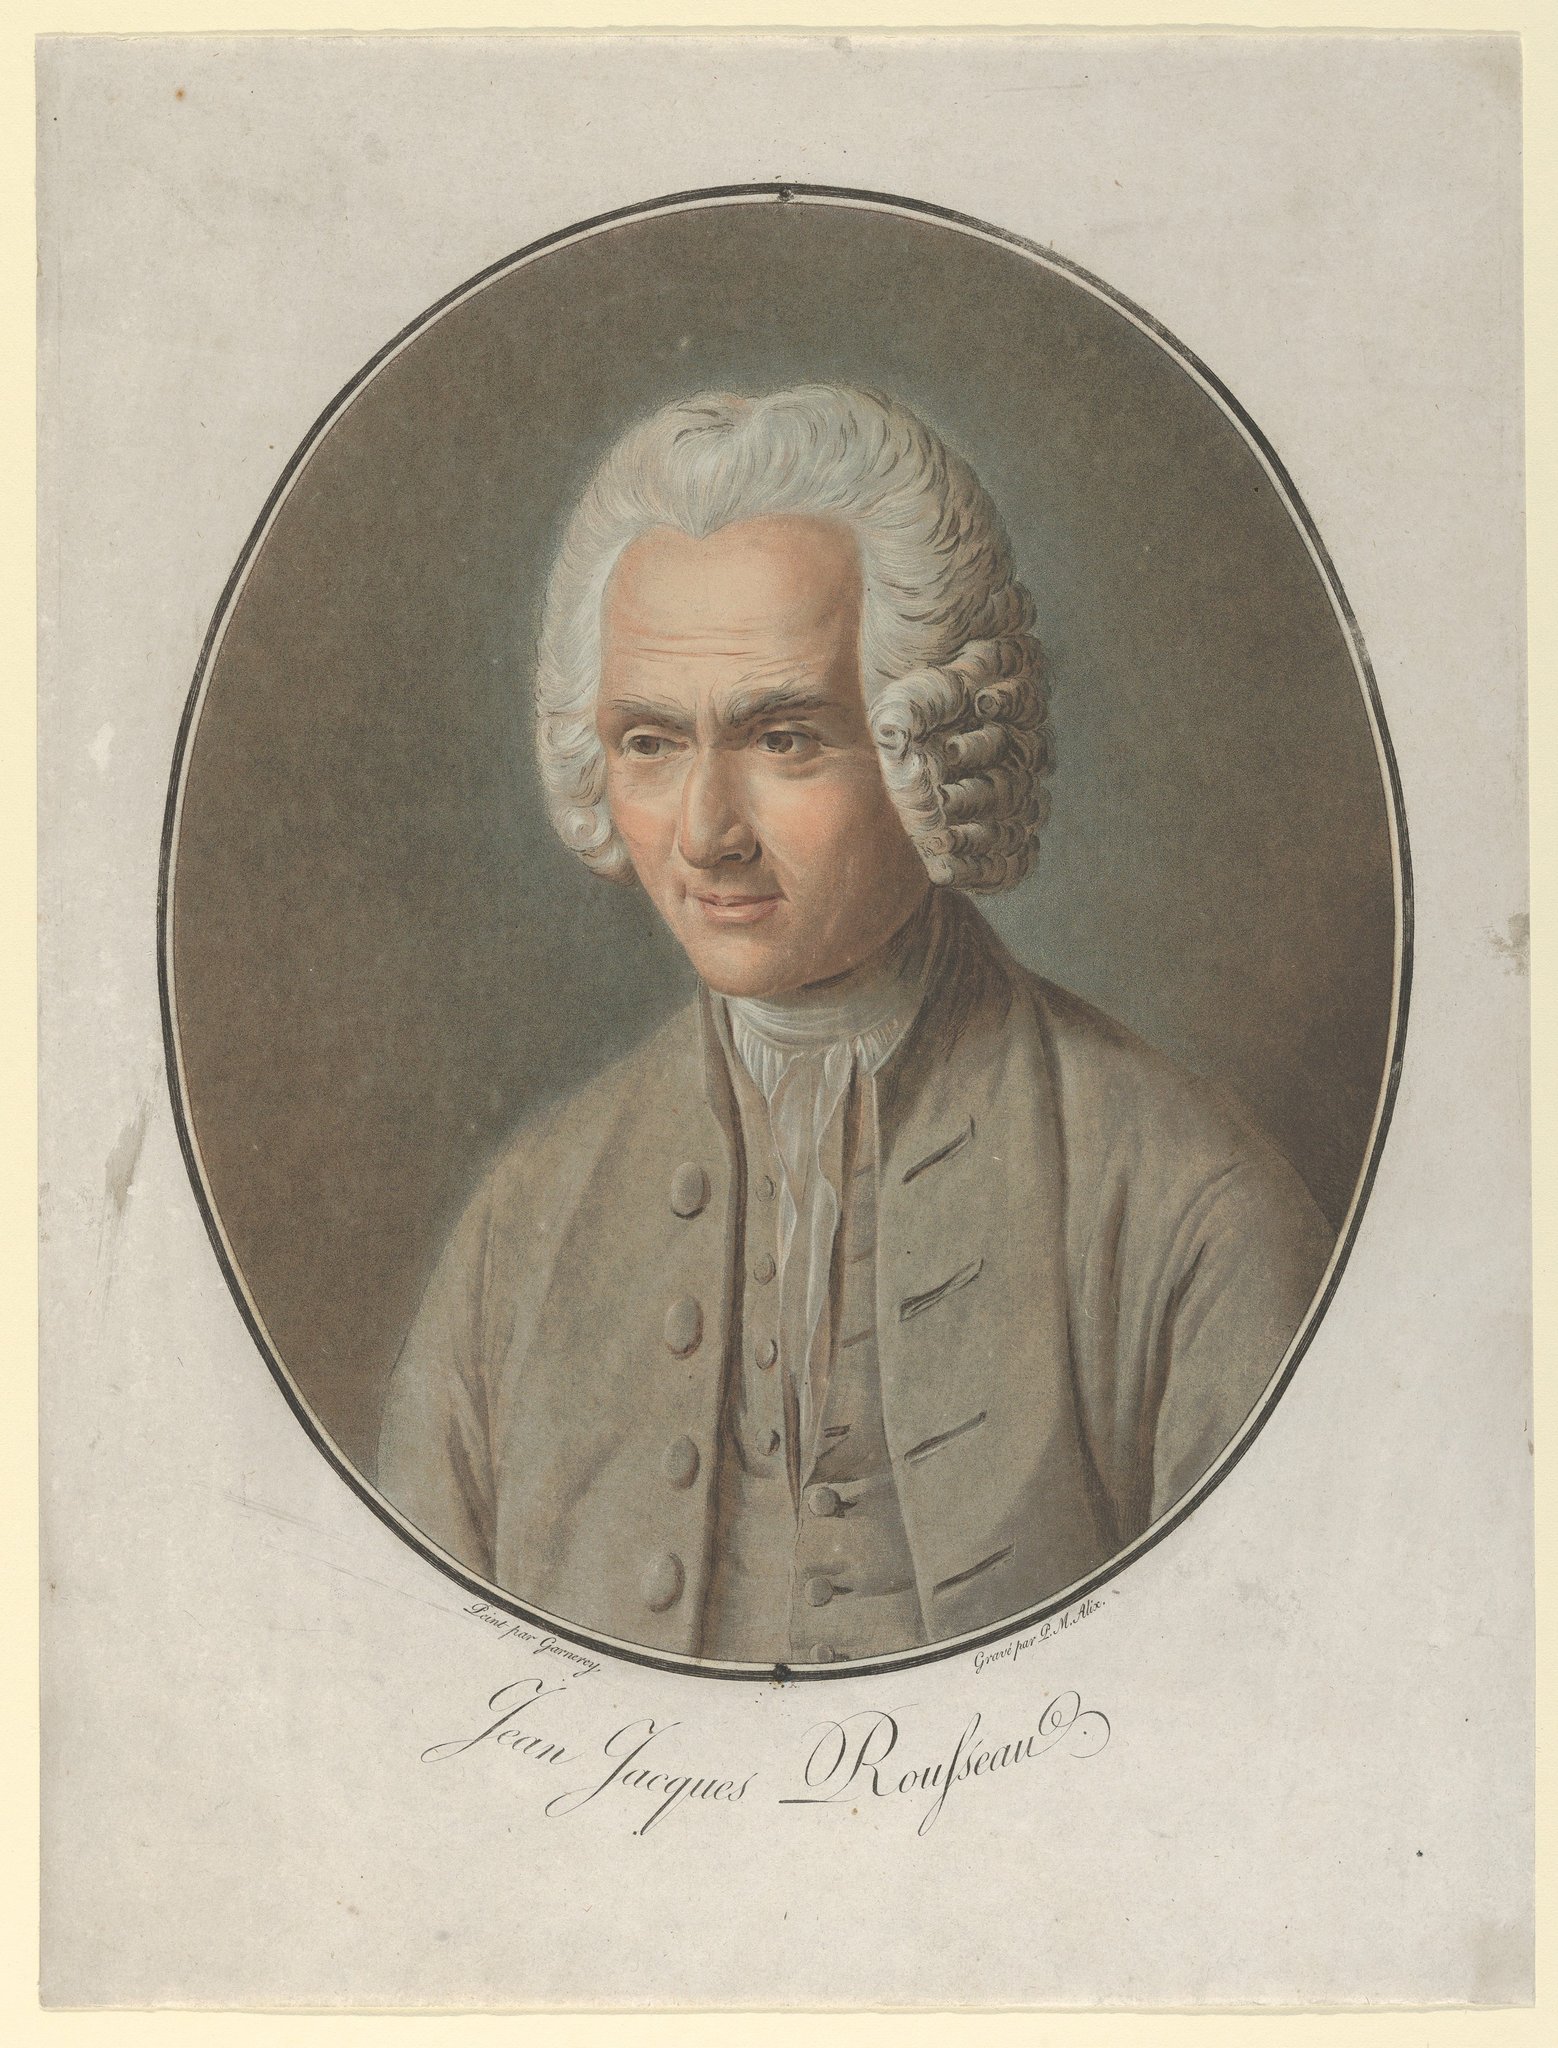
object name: print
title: Jean-Jacques Rousseau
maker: pierre michel alix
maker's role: artist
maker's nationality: french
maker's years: 1762-1817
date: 1791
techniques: aquatint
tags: men,portraits